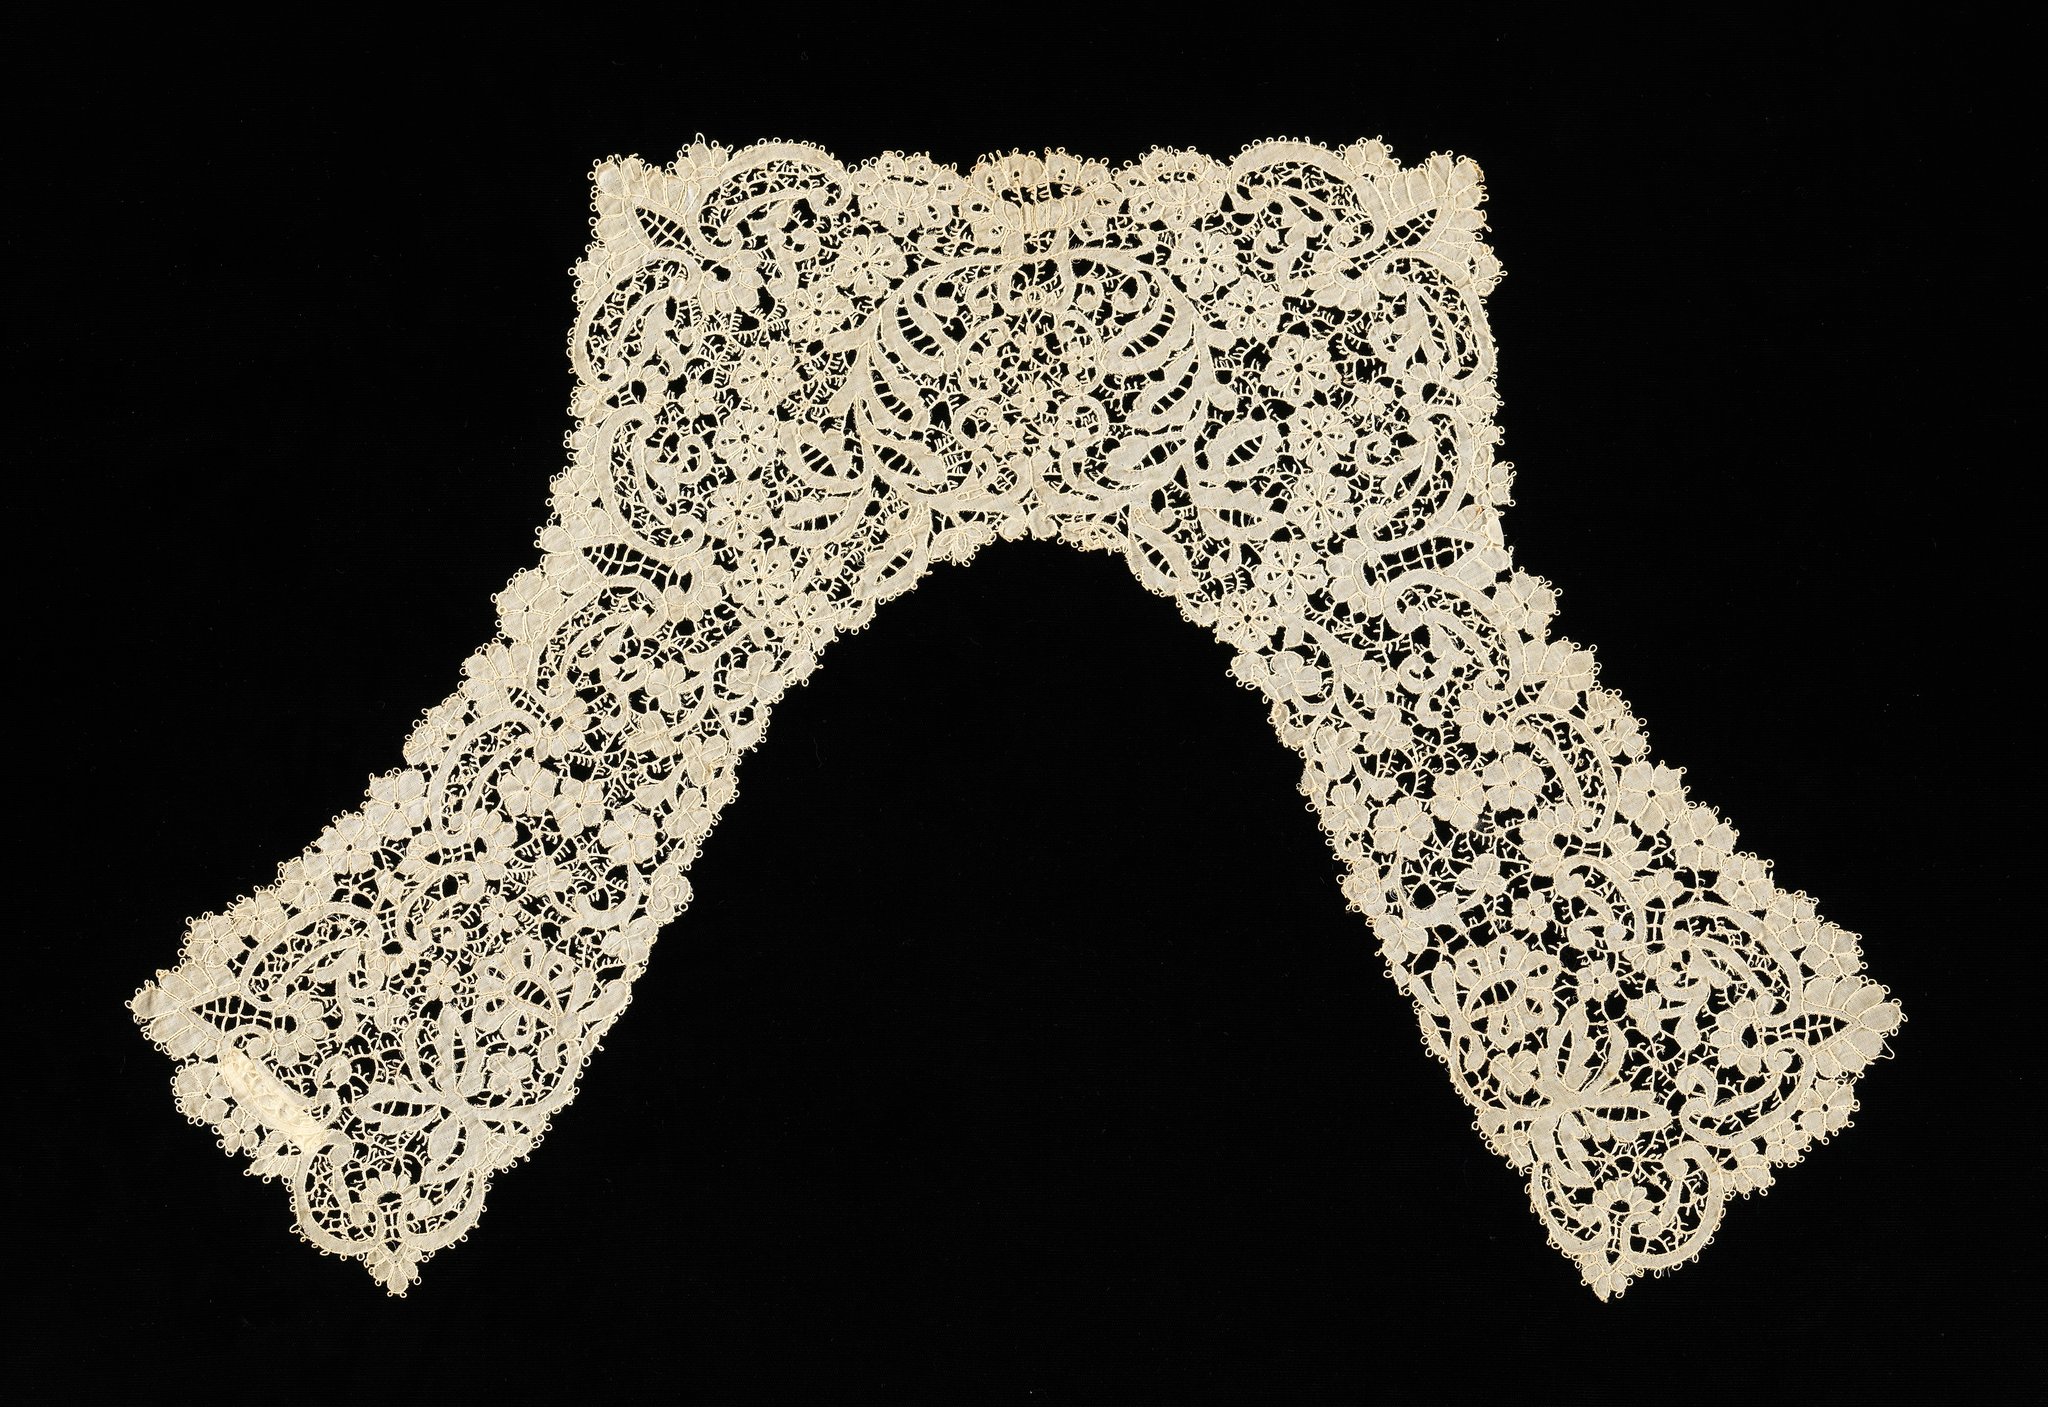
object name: collar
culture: irish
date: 1890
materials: cotton